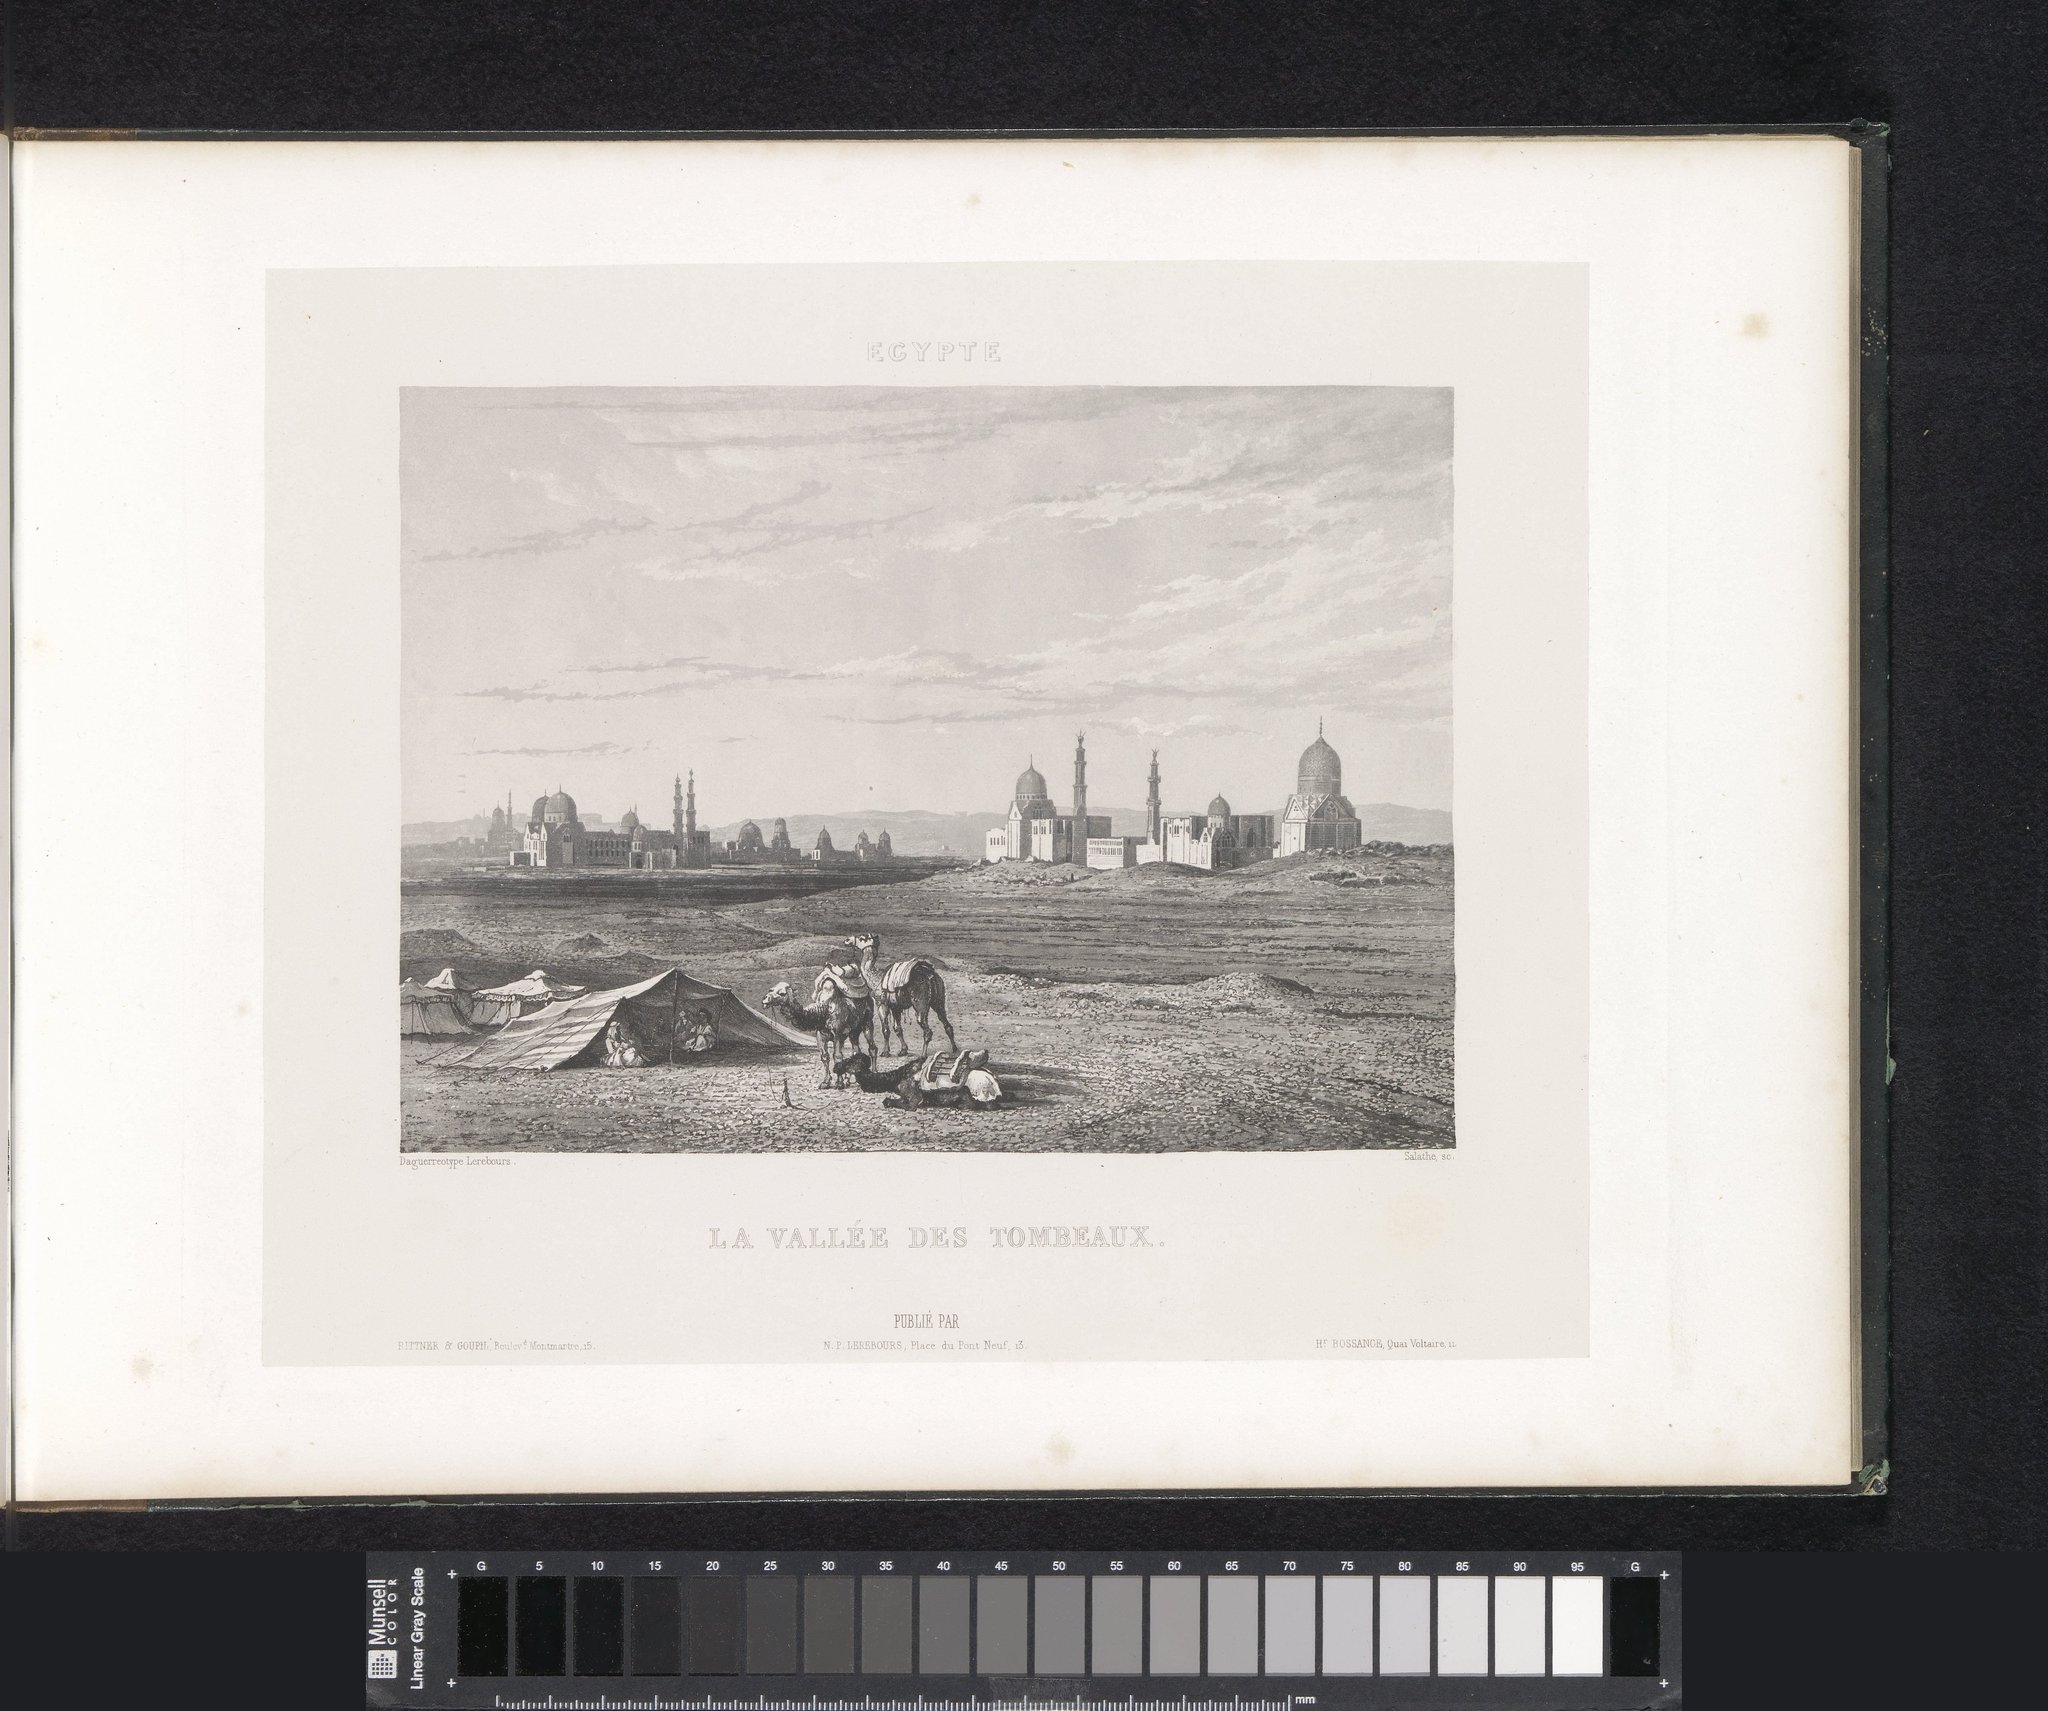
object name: print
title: La vallée des tombeaux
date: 1839-1841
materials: paper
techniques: aquatint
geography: paris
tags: dale, valley, grave, tomb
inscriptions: inscription: ‘Rittner & Goupil Boulevd Montmartre 15’, inscription: ‘Hr. Bossance Quai Voltaire 11’, inscription: ‘N.P. Lerebours Place du Pont Neuf 15’